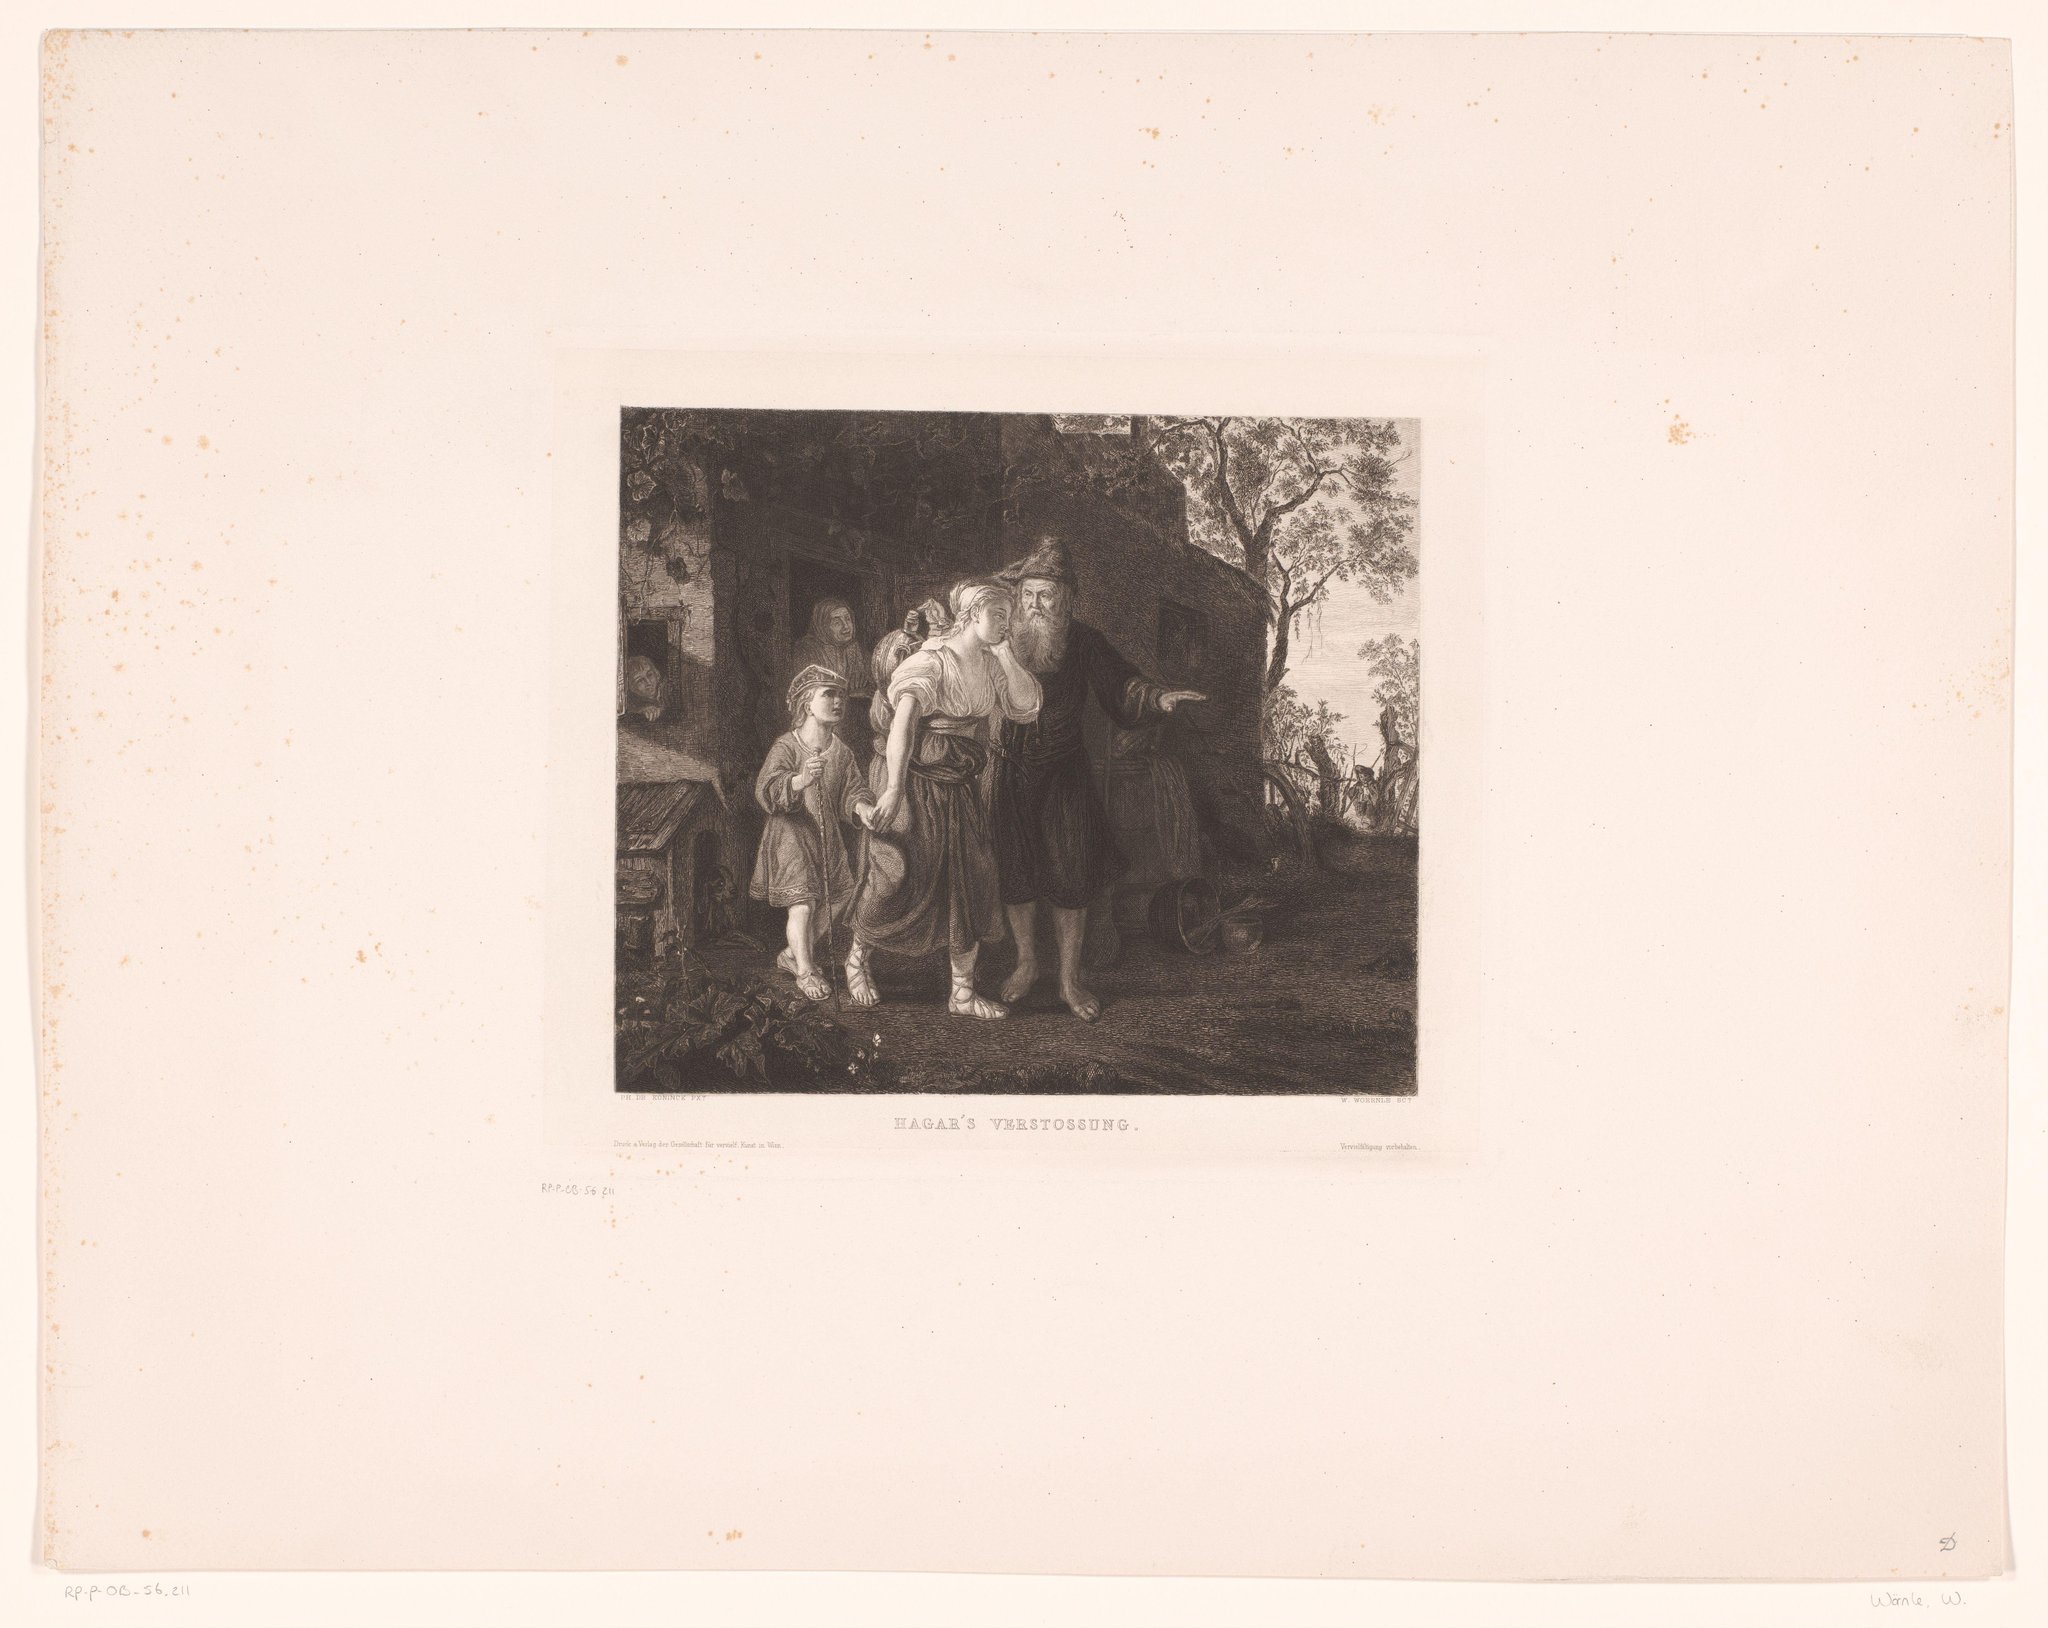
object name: print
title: Hagar's Verstossung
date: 1859-1916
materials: paper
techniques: etching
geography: austria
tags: the banishment of hagar and ishmael (genesis 21:9-21)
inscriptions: collector's mark: Lugt 2228